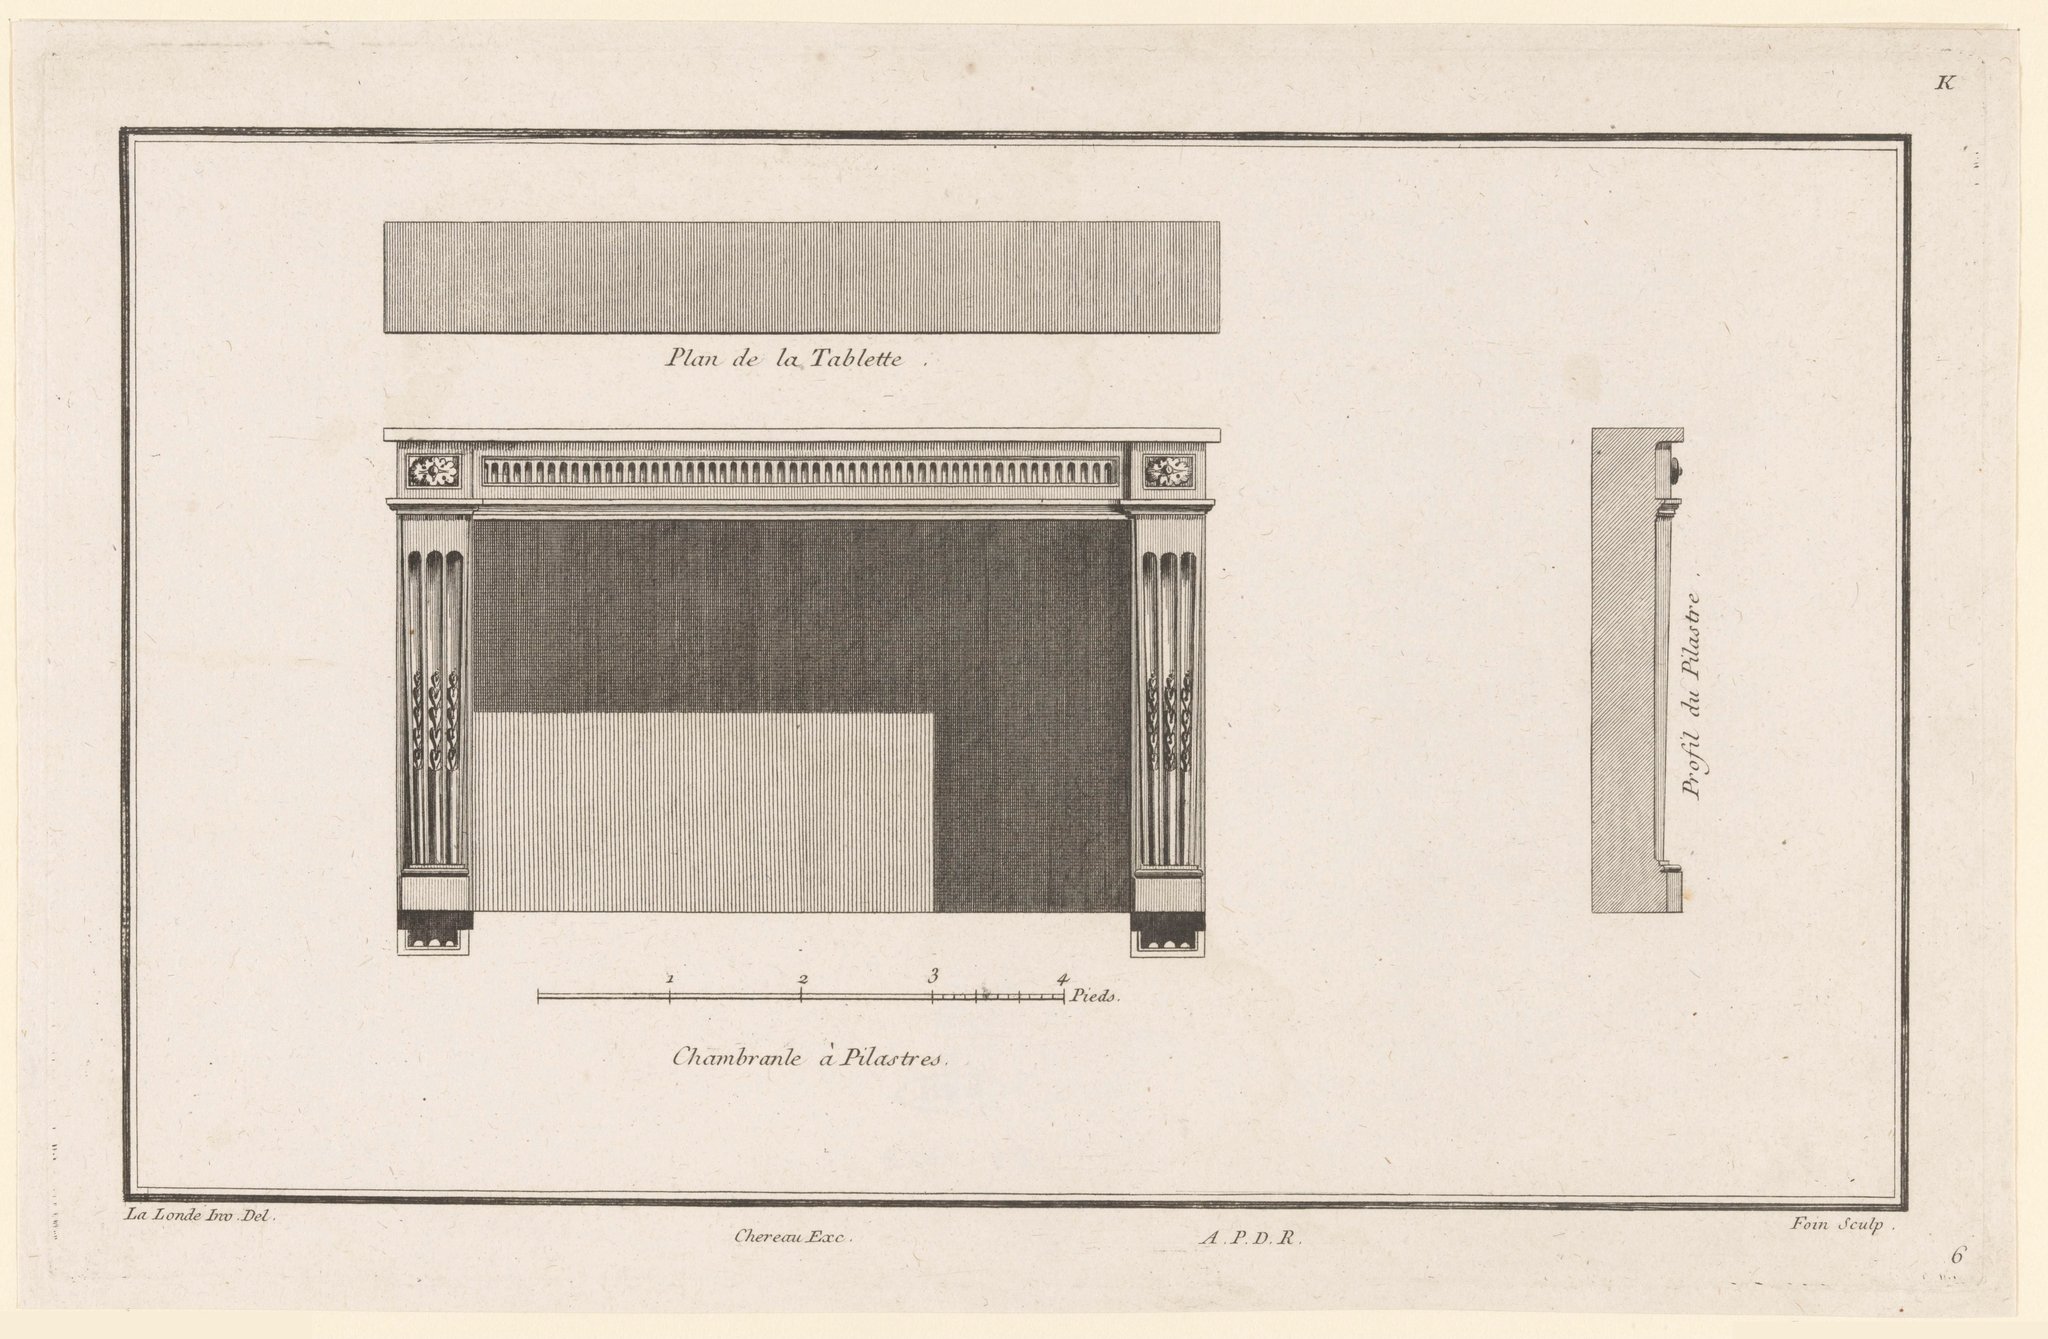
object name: print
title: Haard met pilasters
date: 1784-1785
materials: paper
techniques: engraving, etching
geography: paris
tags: open hearth, fire-place, half-column, pilaster ~ architecture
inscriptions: collector's mark: Lugt 2760, collector's mark: Lugt 2228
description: Voor-, zij- en bovenaanzicht van een geornamenteerde haard met pilasters.